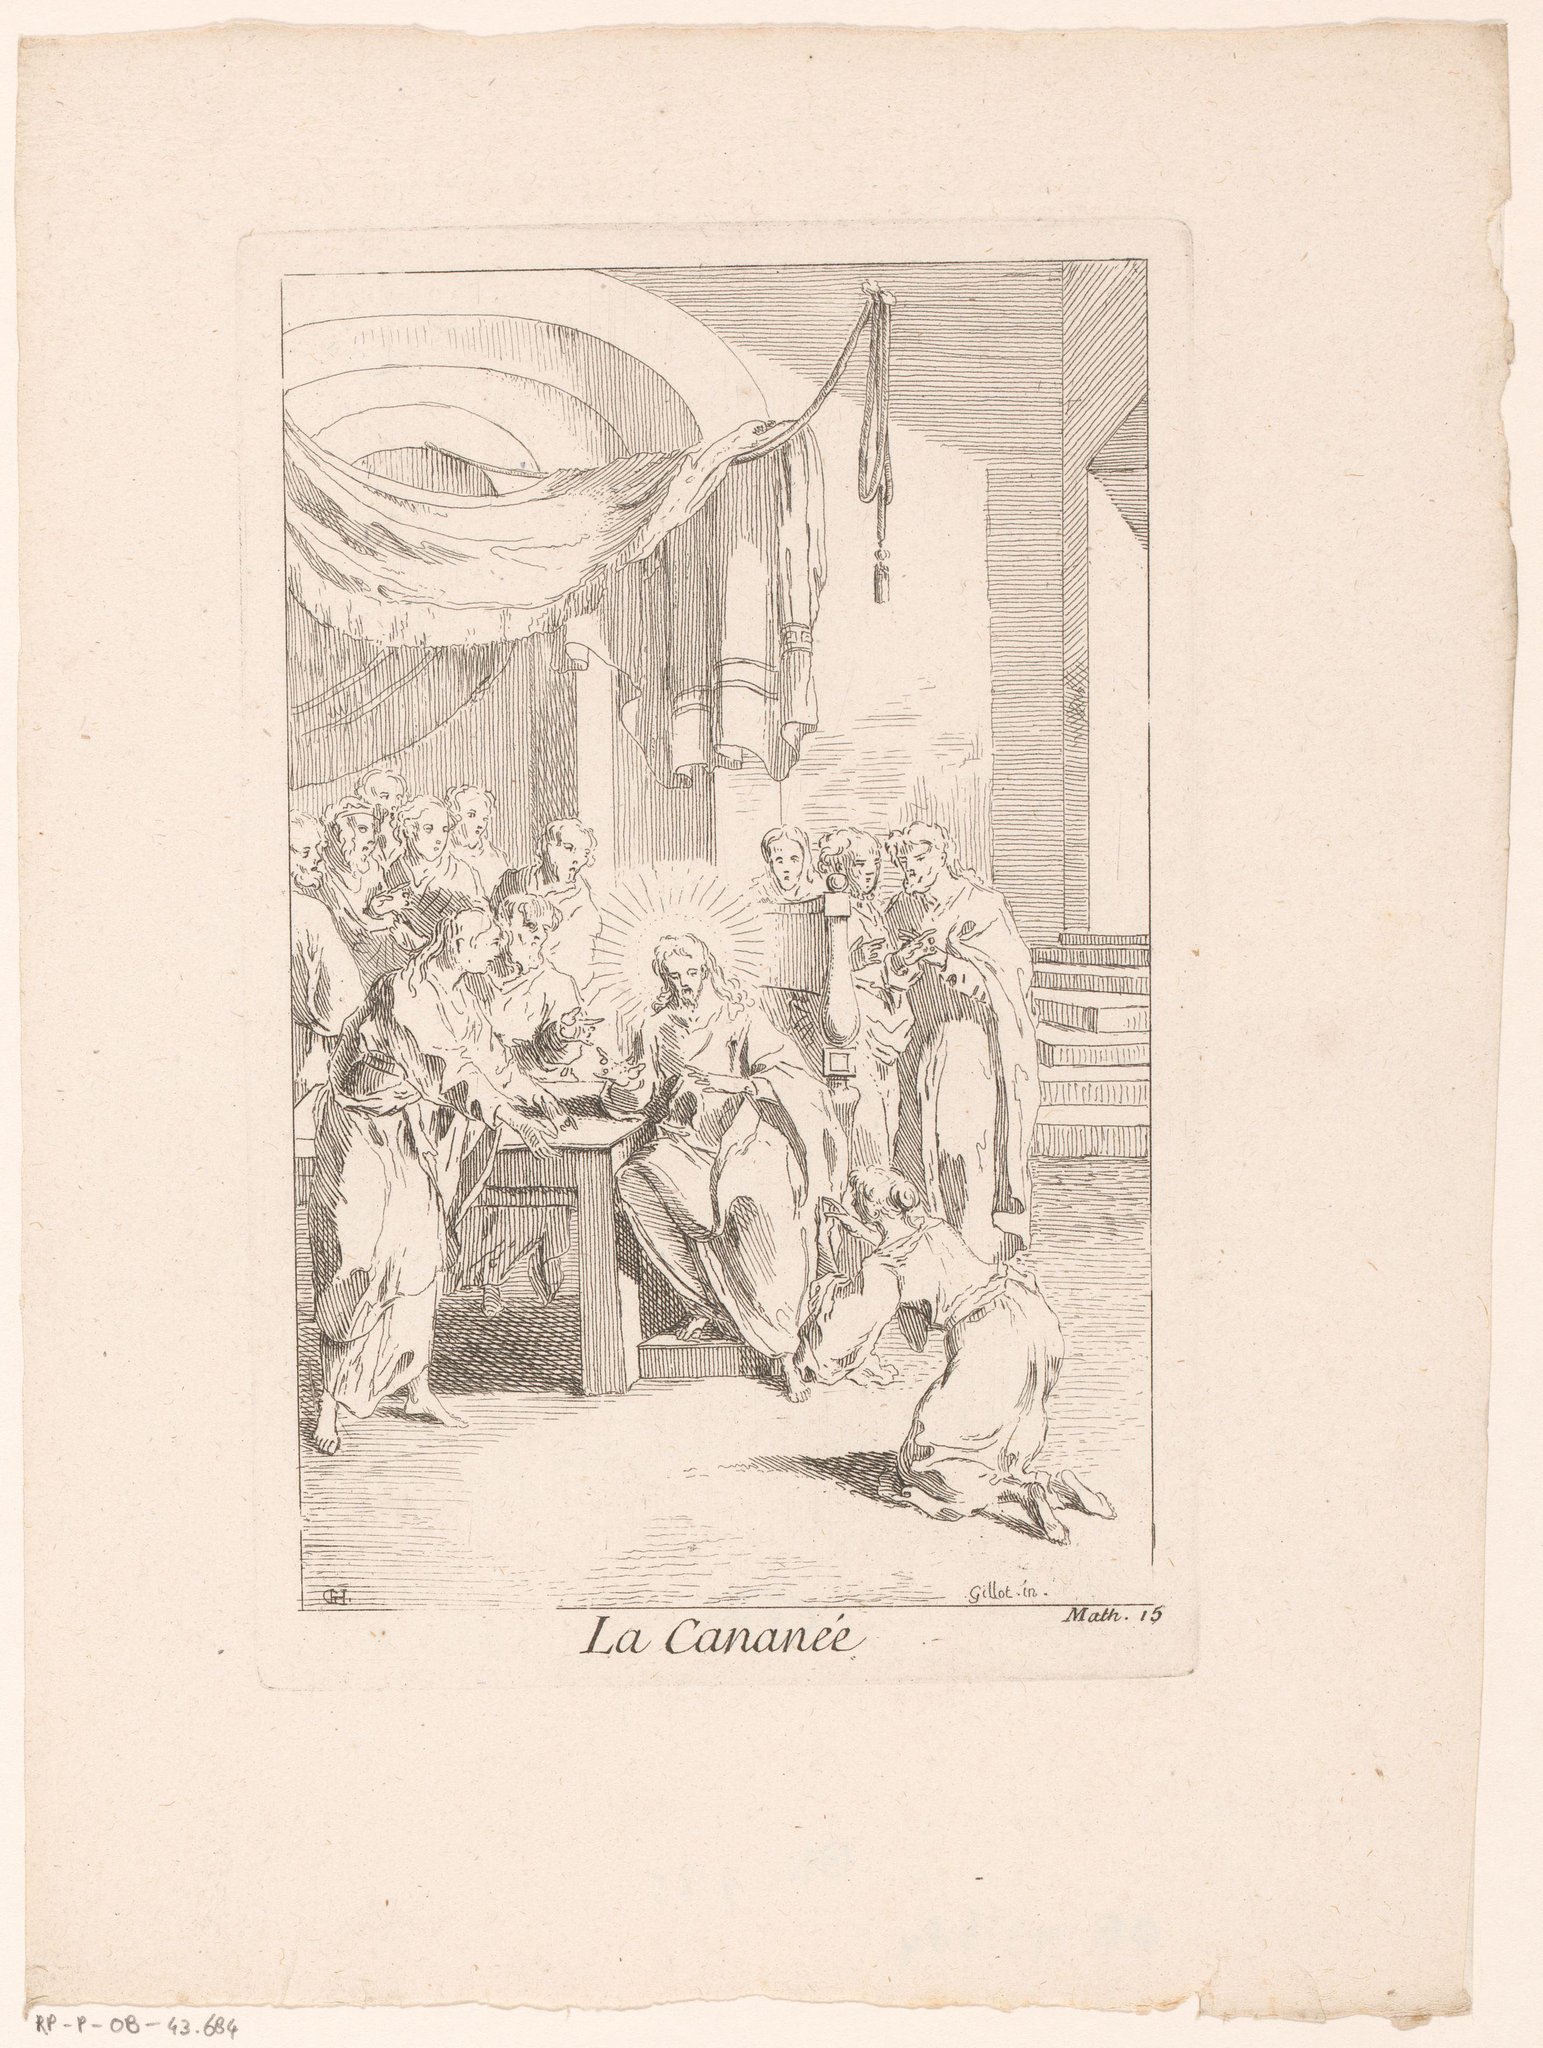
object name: print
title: Leven en passie van Christus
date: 1705-1732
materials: paper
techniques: etching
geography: paris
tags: a canaanite woman kneels before christ, asking him to heal her daughter; the metaphor of the dogs and bread (matthew 15:21-28; mark 7:24-30)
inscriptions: collector's mark: Lugt 2228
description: Maakt deel uit van een serie met zestig prenten met als thema het leven van Christus.